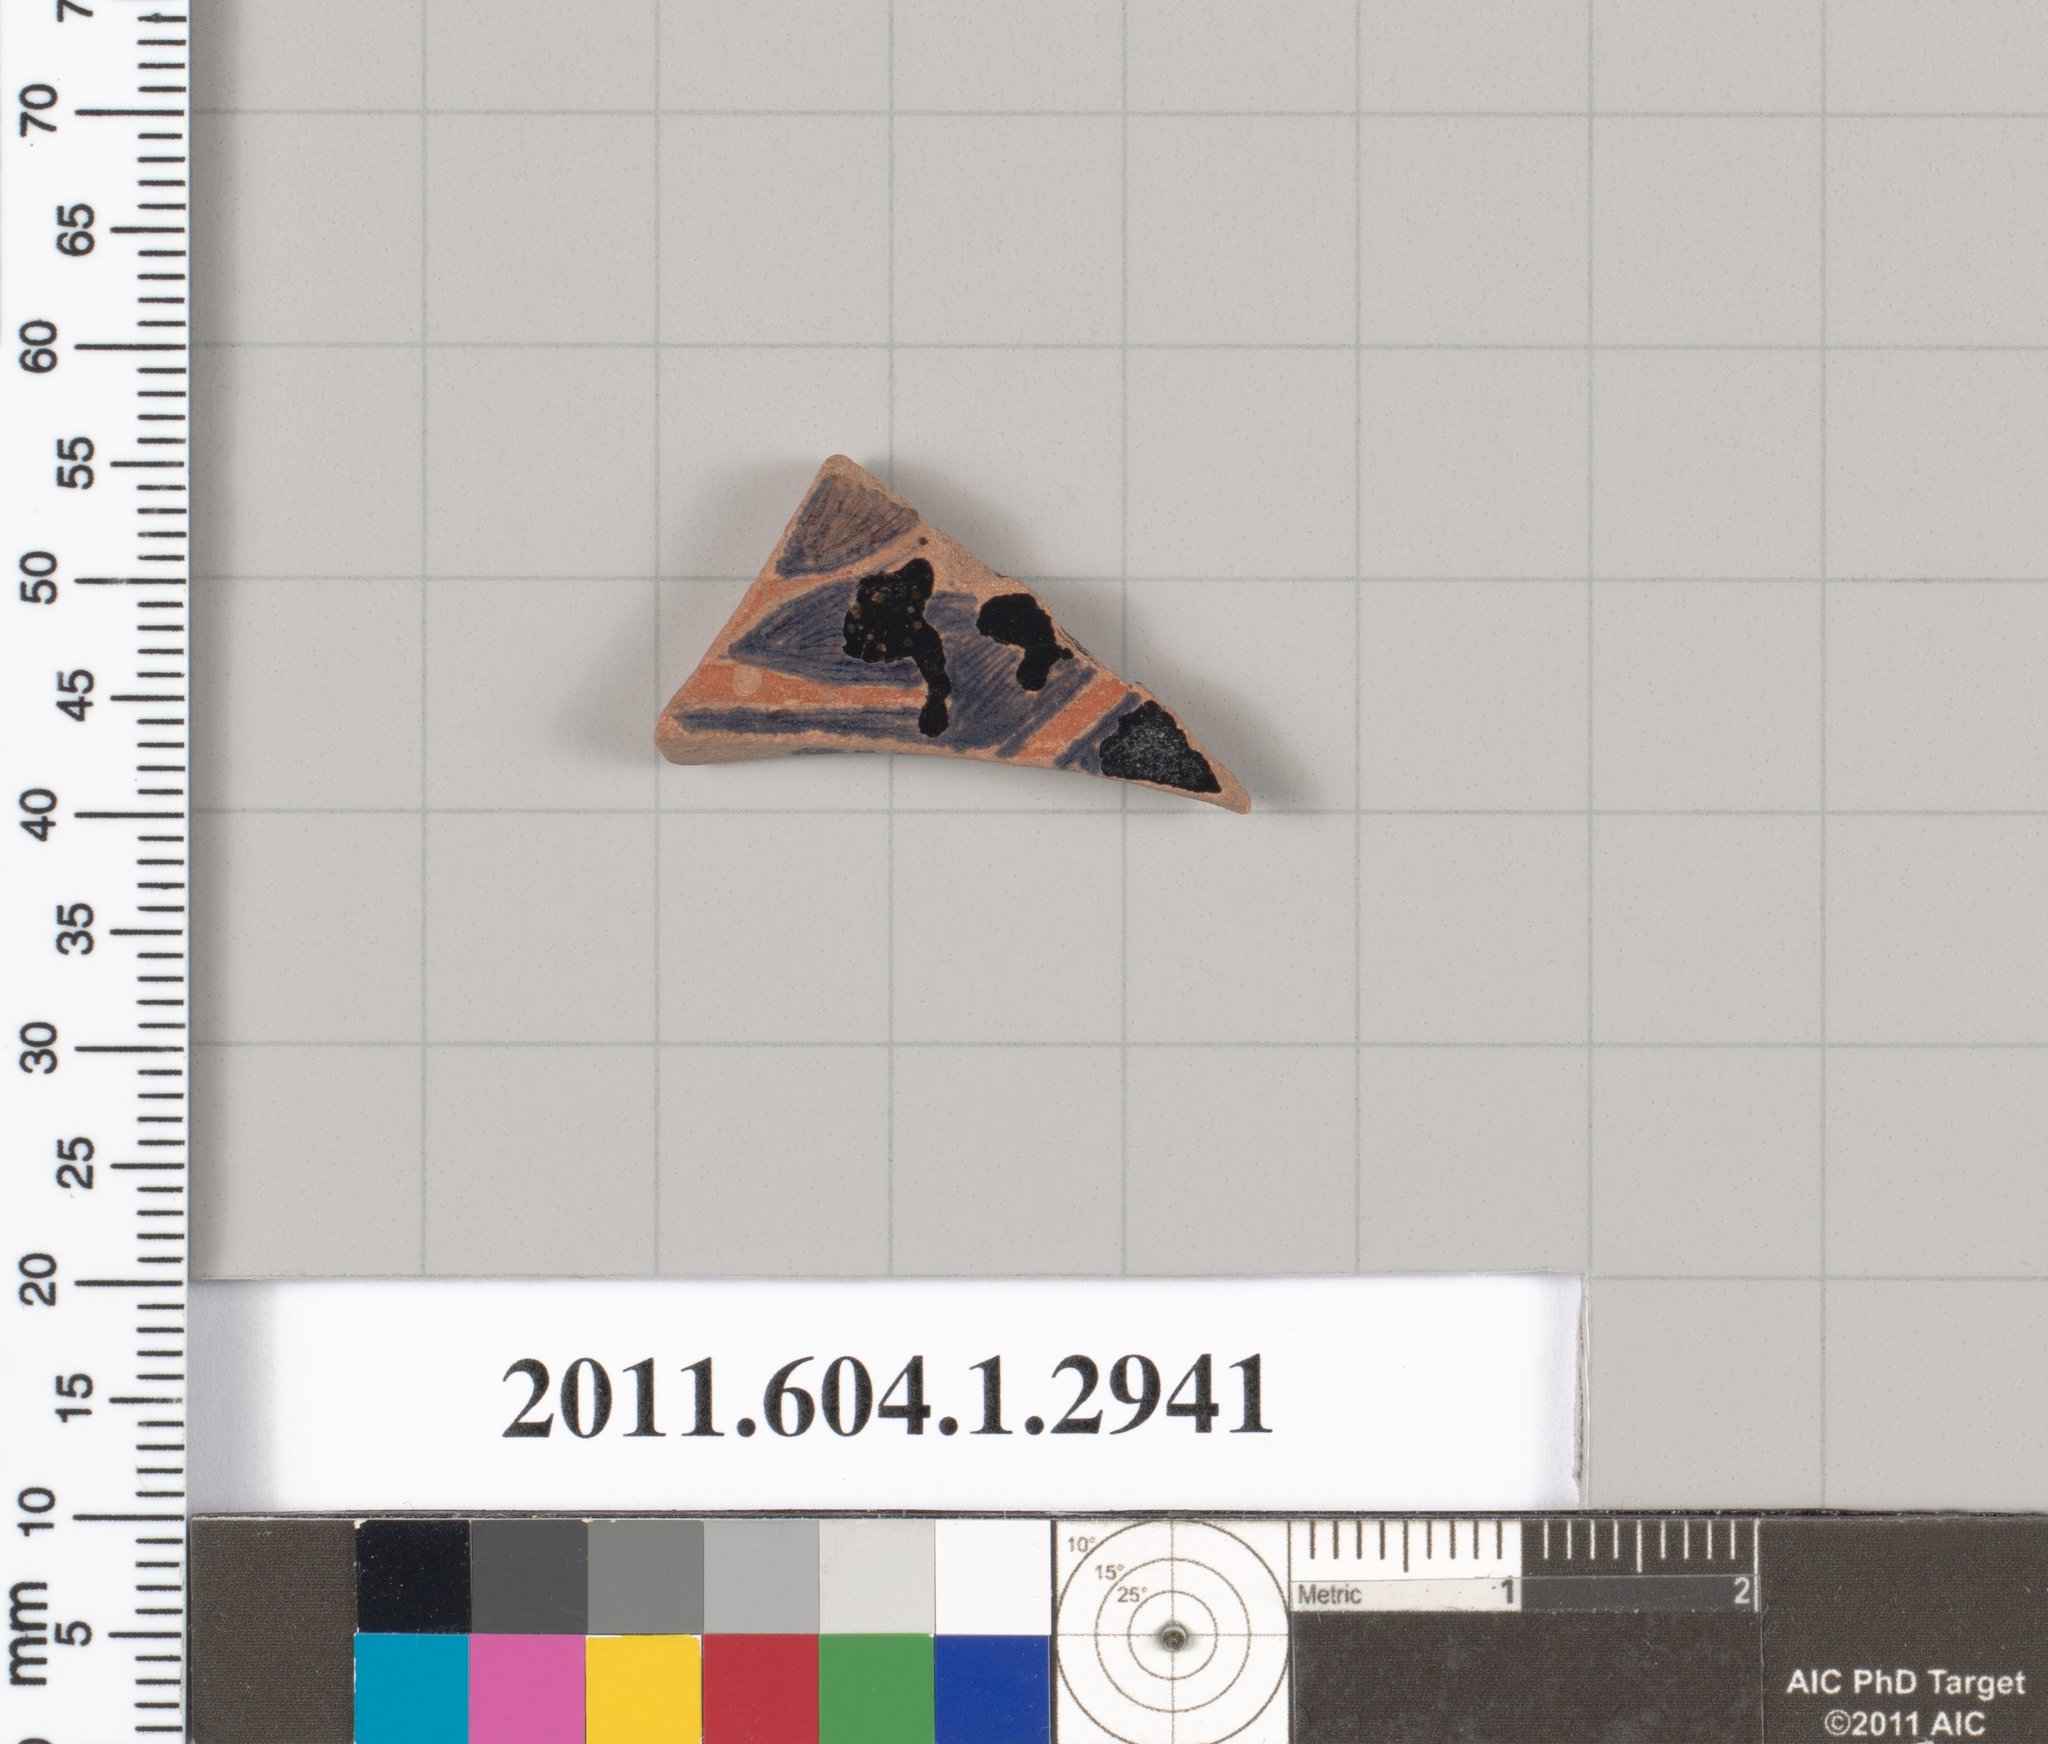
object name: kylix fragment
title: Terracotta fragment of a kylix (drinking cup)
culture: greek, attic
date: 500-476 BCE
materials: terracotta